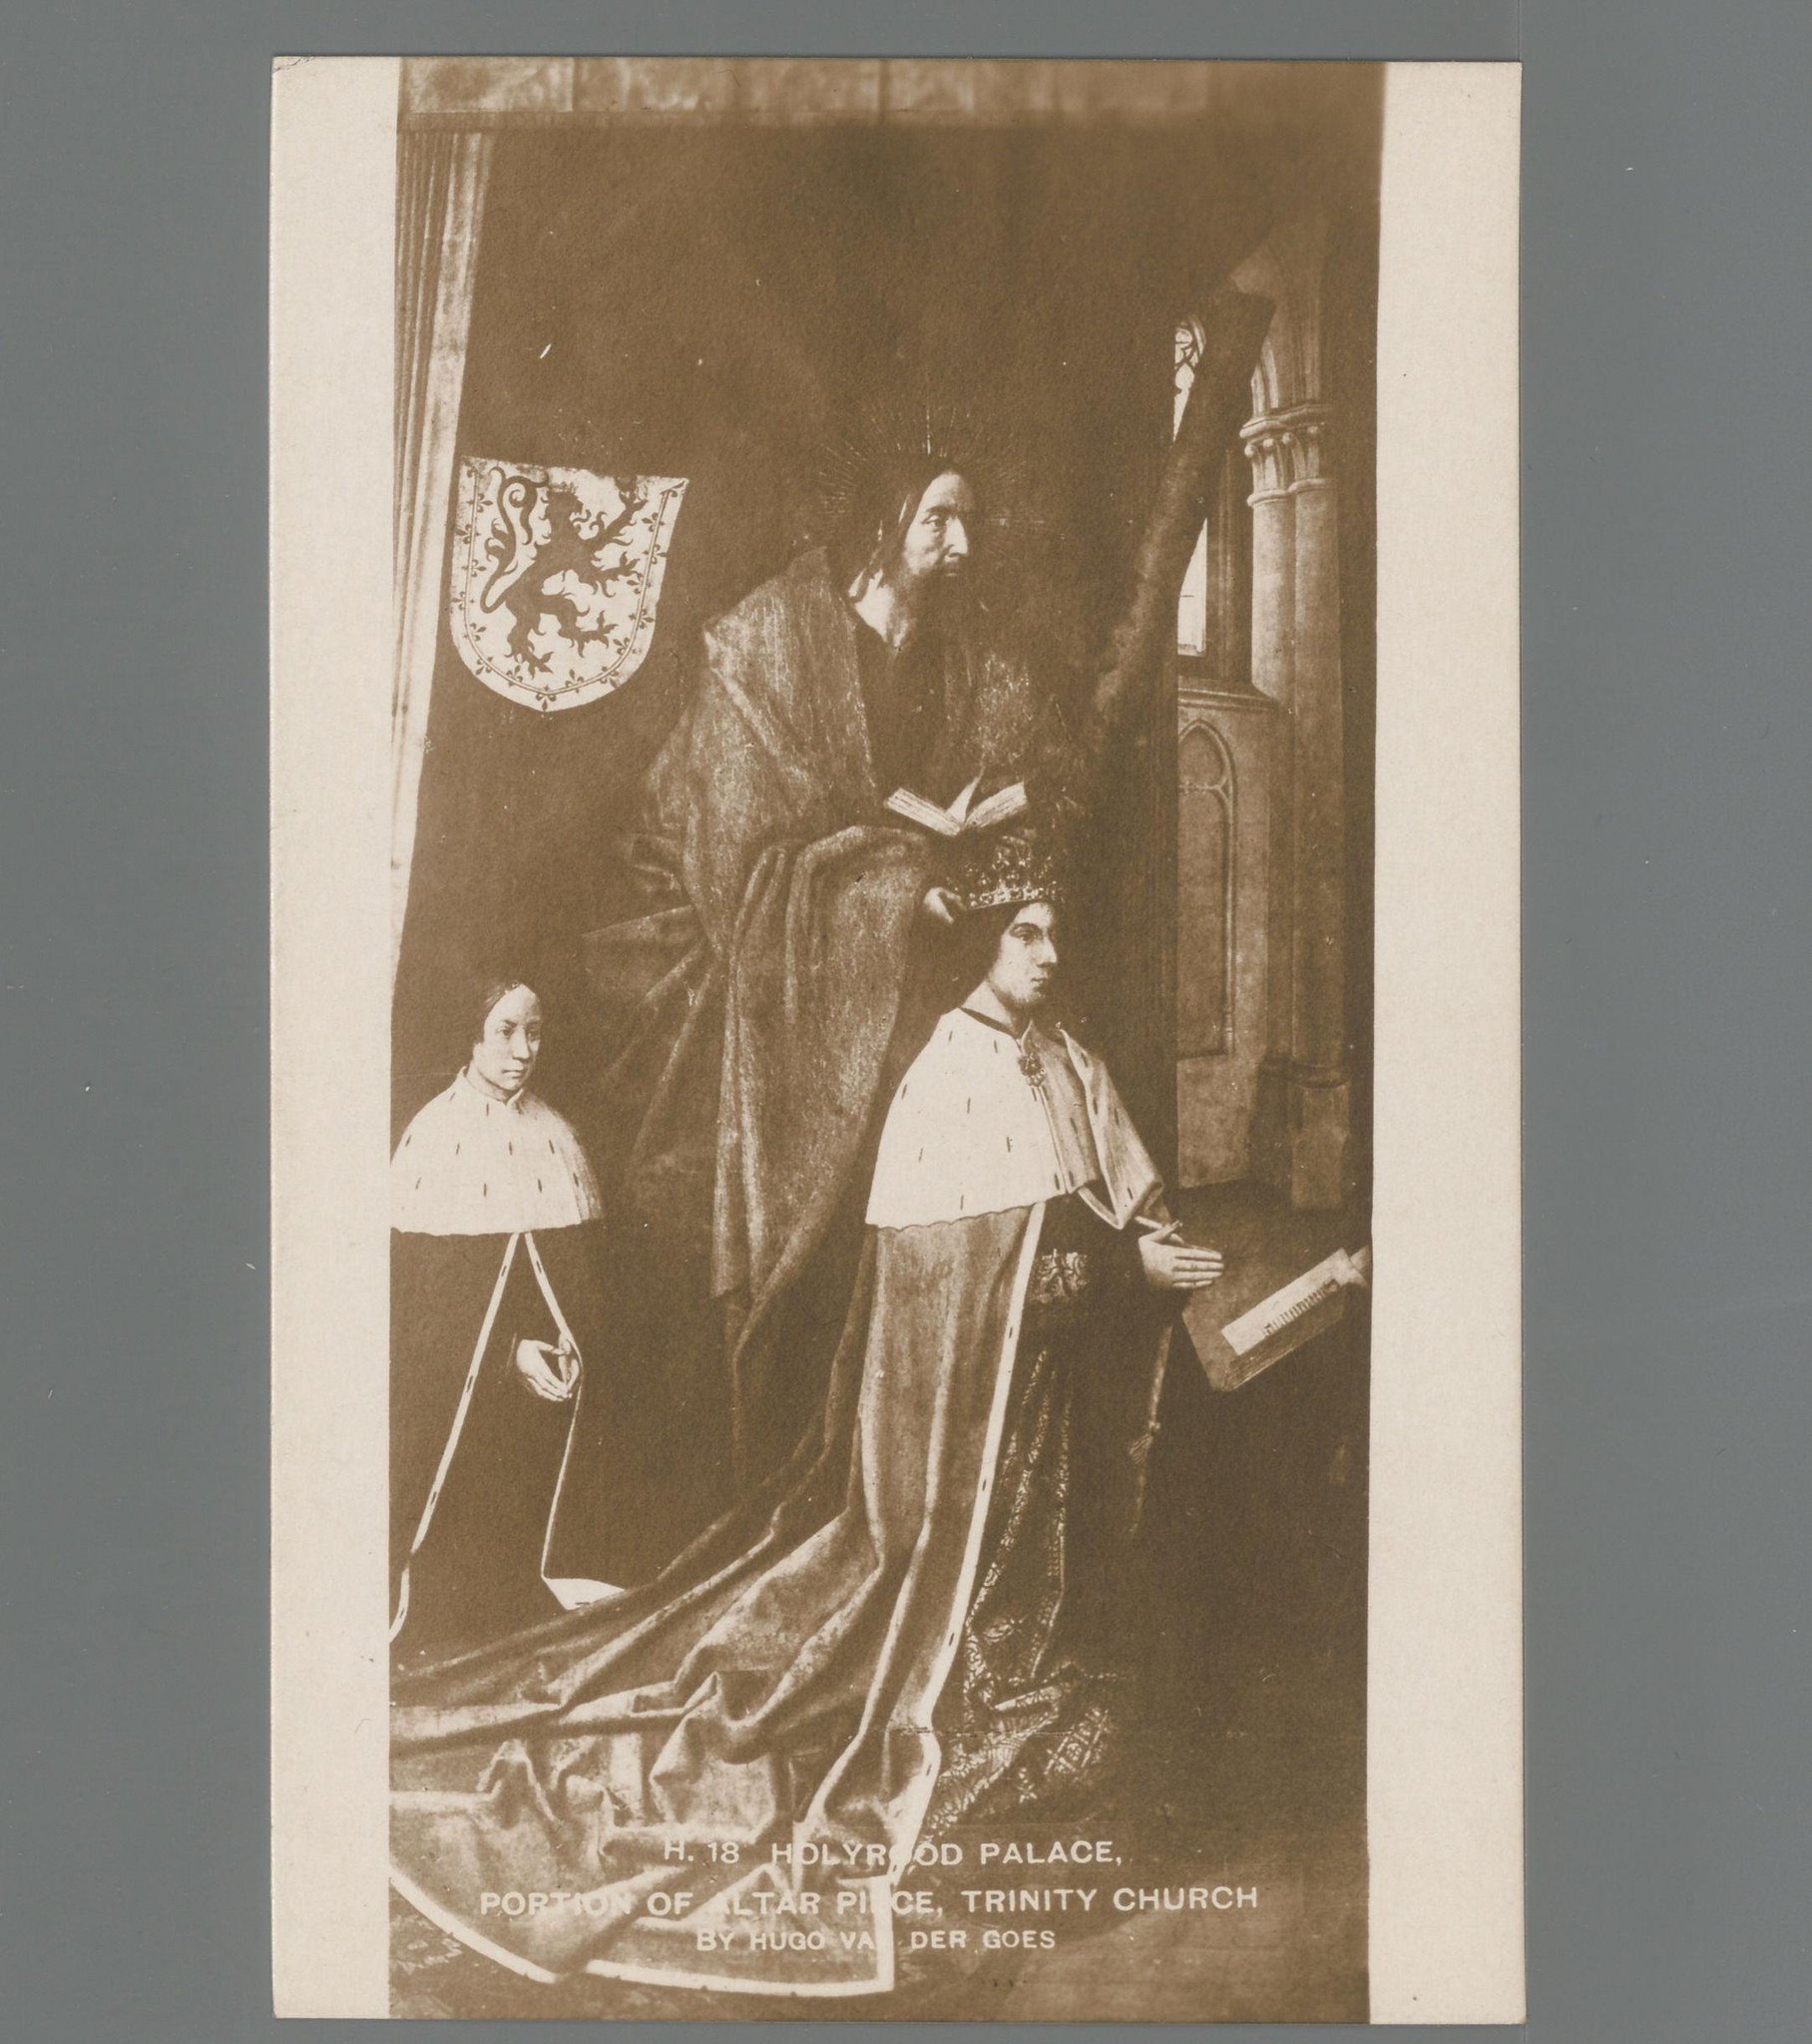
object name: reproduction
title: Holyrood Palace, portion of altar piece, Trinity Church. By Hugo van der Goes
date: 1902-1940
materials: photographic support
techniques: photography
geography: great britain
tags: church (exterior), picture, painting